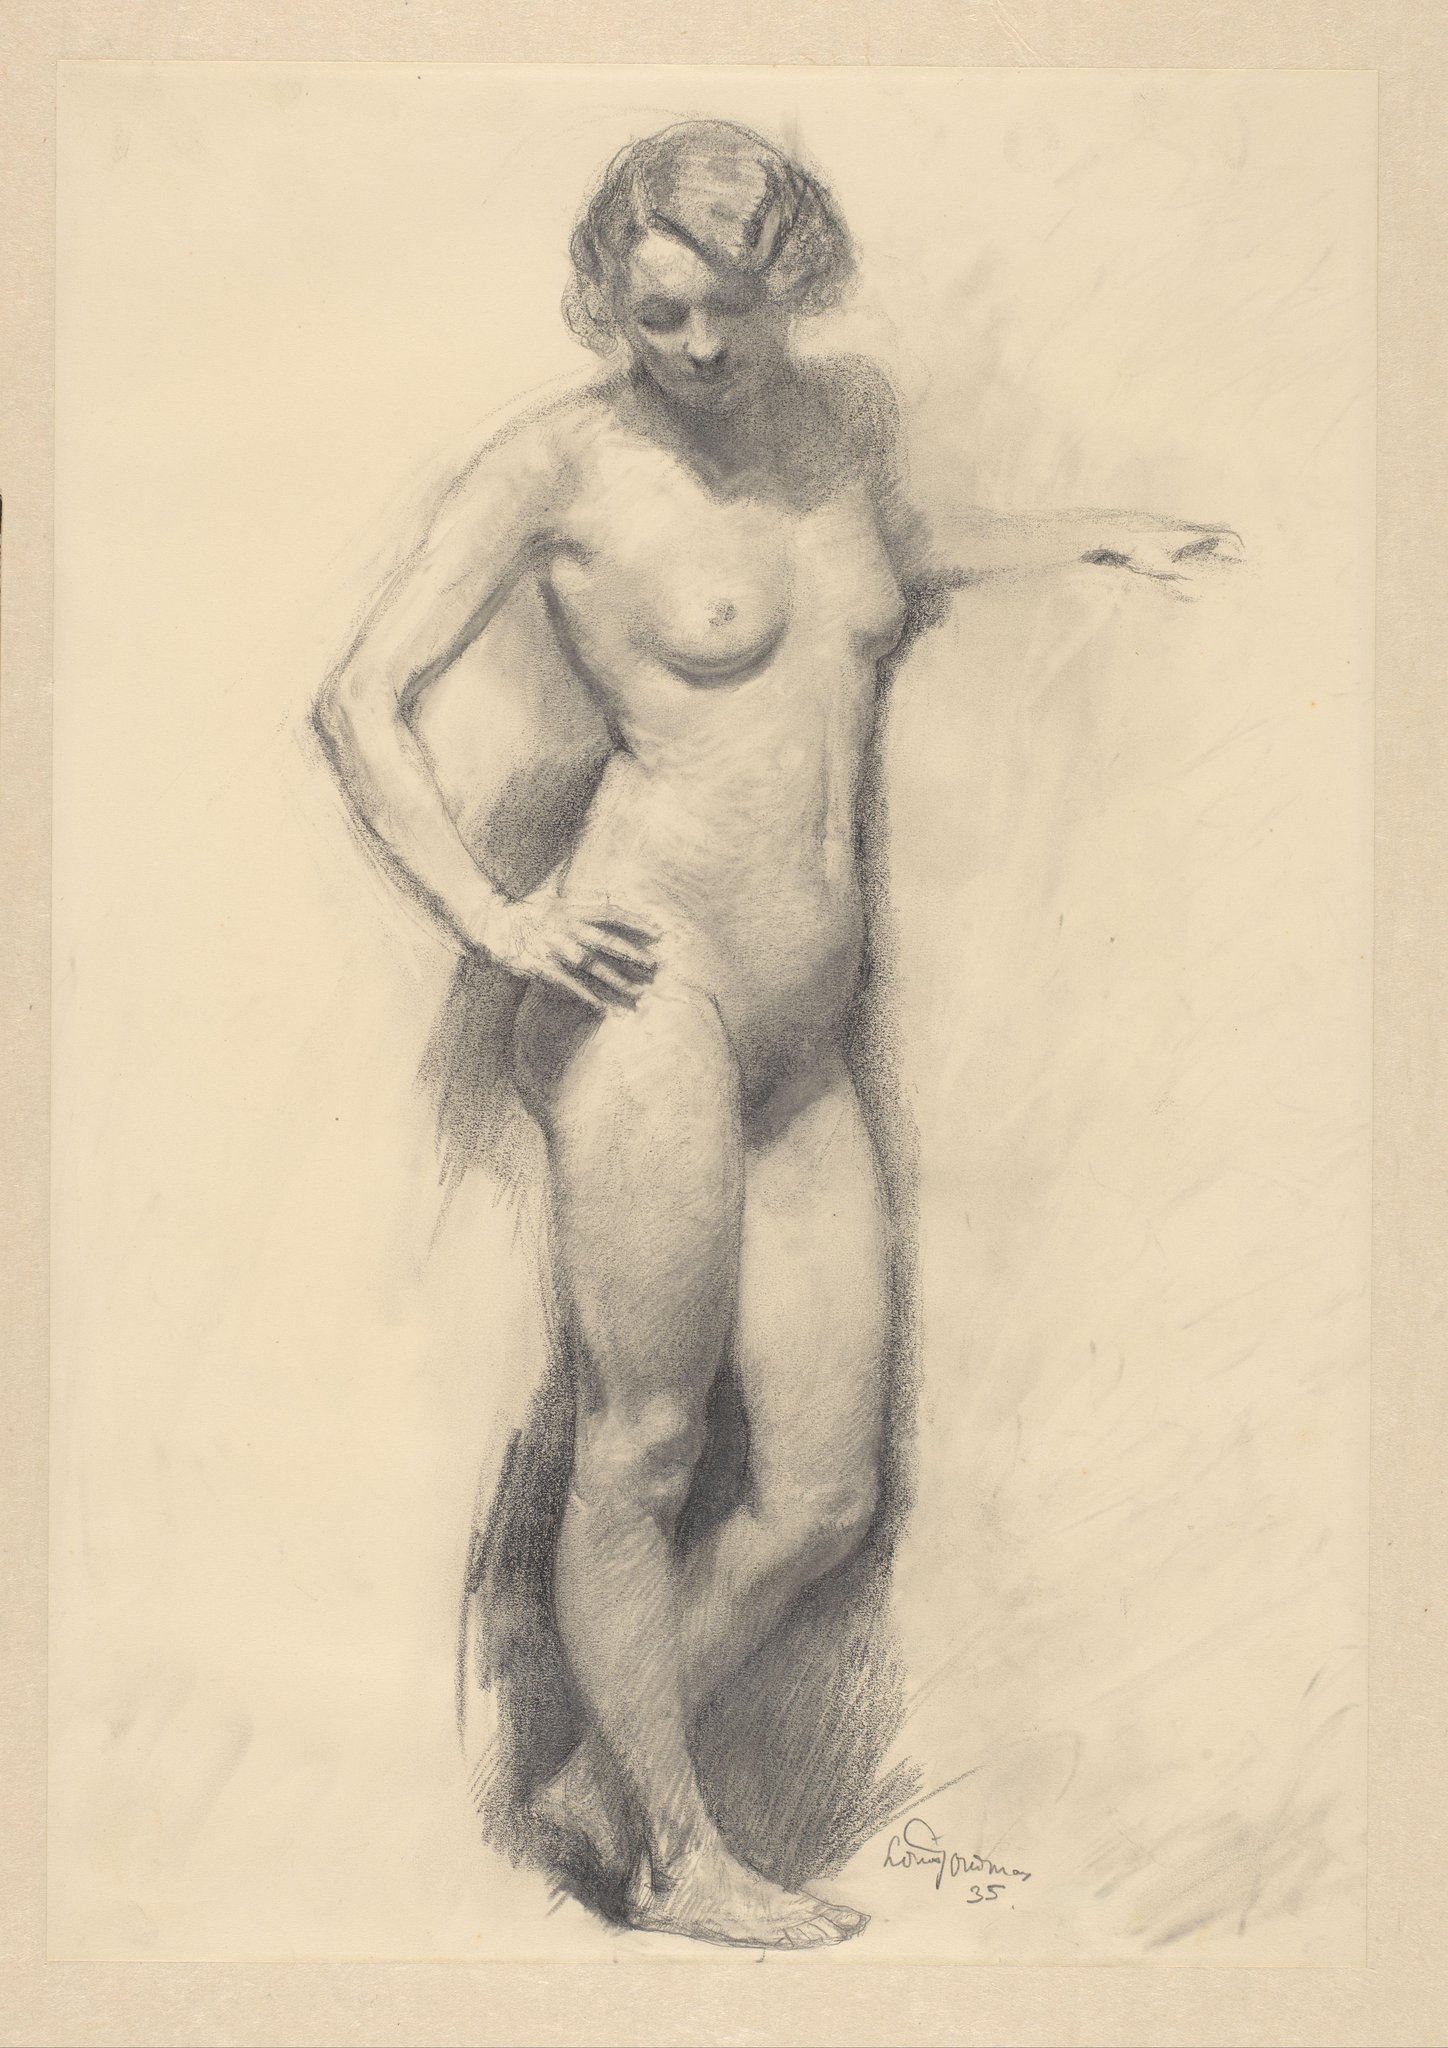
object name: drawing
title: Standing Female Nude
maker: louis goudman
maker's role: draughtsman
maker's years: 1880-1939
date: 1935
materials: chalk, paper, pencil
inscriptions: date: ‘35’